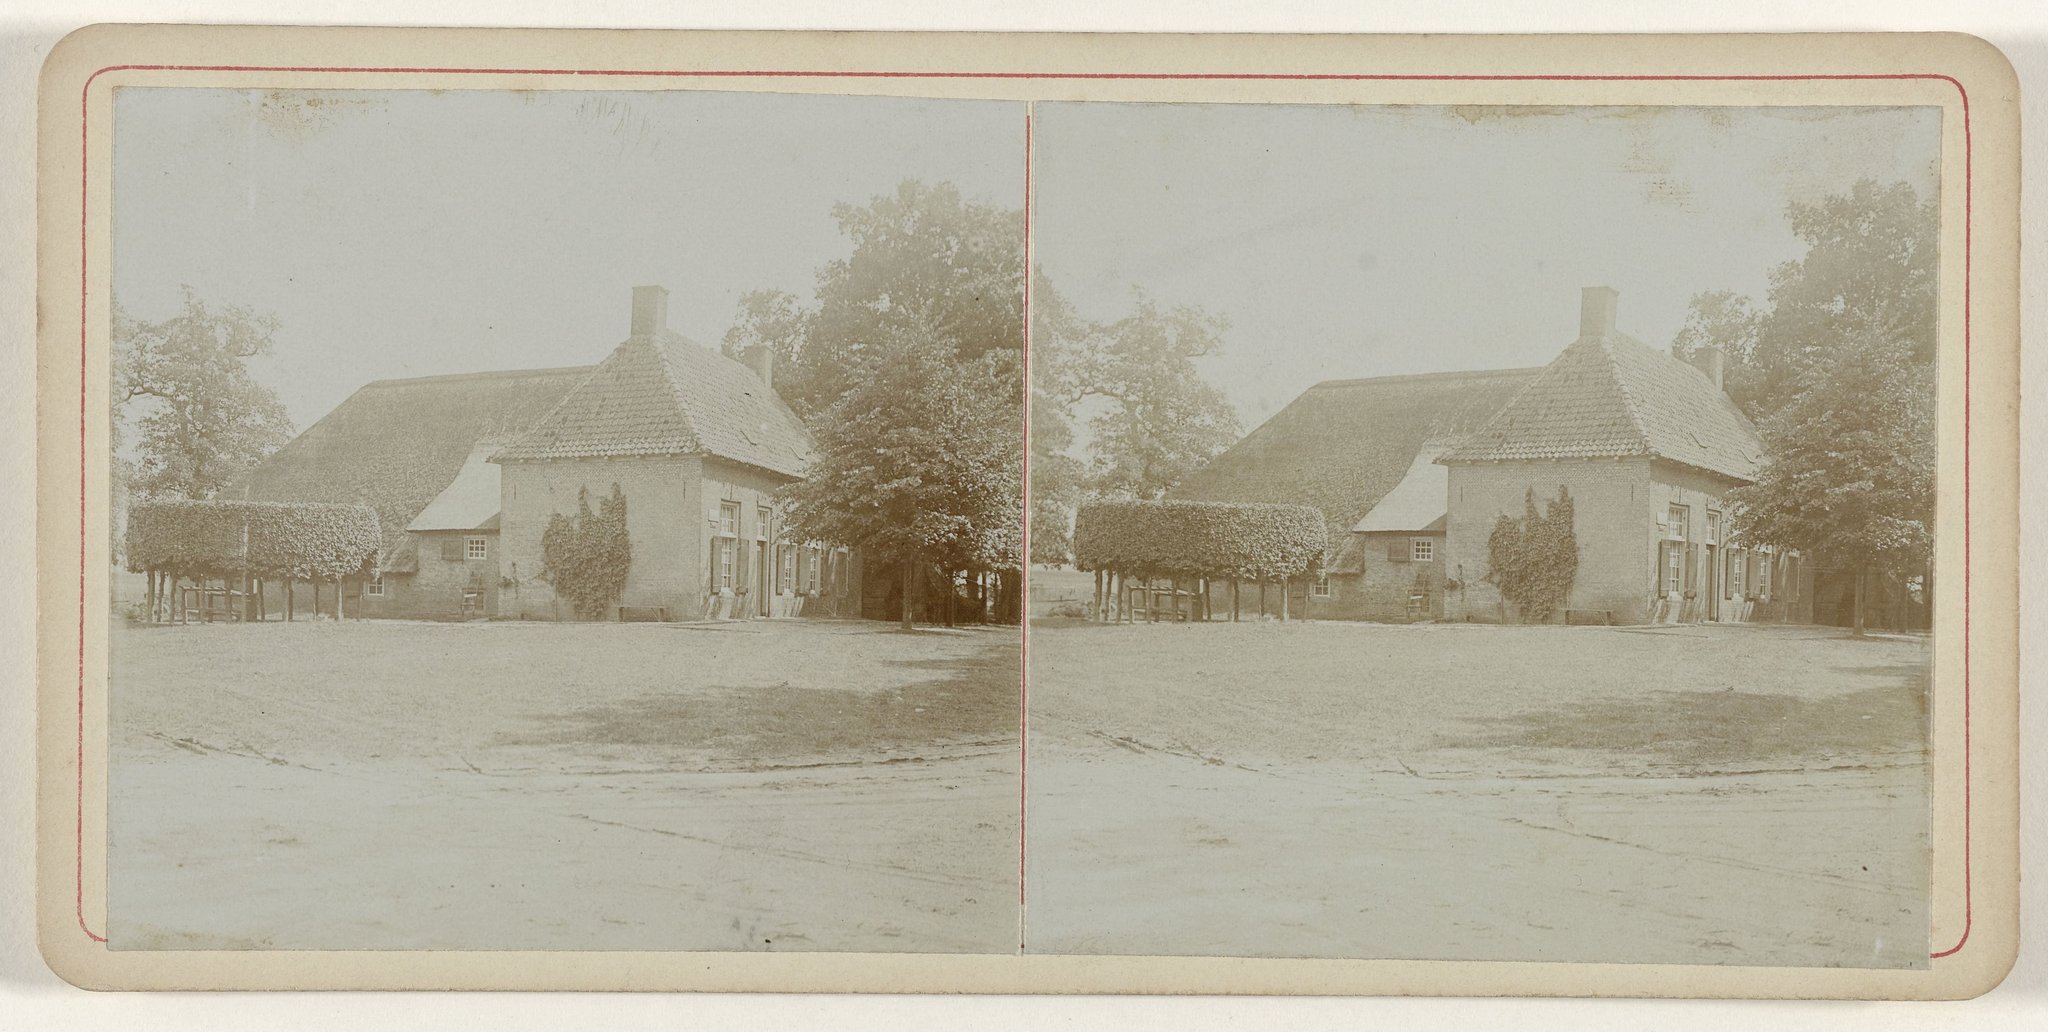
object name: stereograph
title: Boerderij bij Uddelermeer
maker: geldolph adriaan kessler (dolph)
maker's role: fotograaf, industrieel, voetballer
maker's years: 1884-1945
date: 1904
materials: paper, photographic support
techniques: collodion silver print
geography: gelderland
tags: uddel